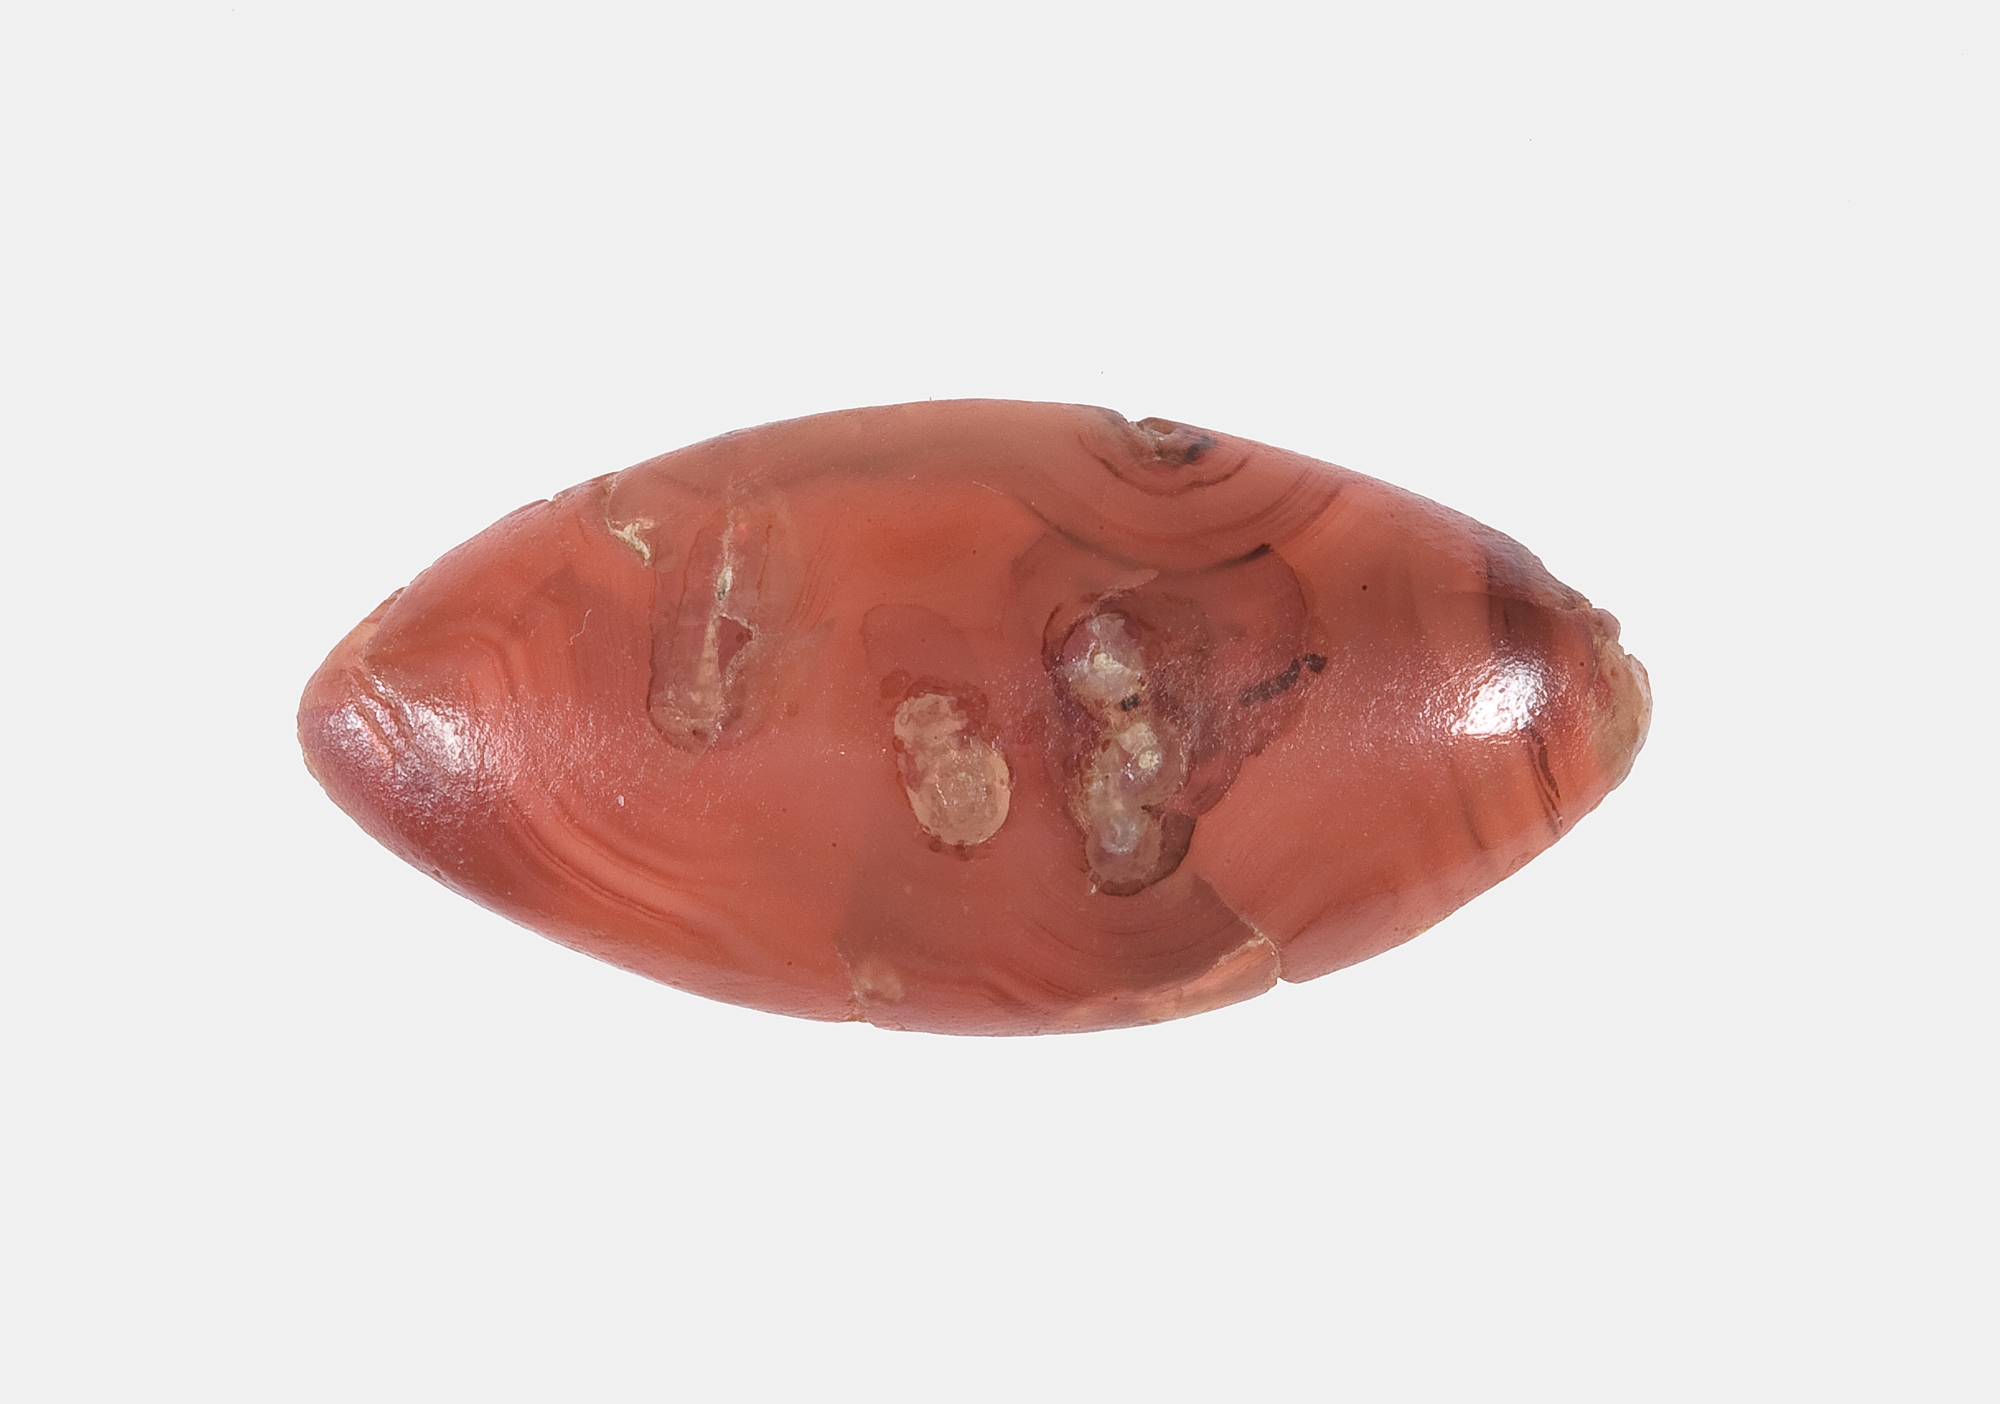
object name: amulet, sweret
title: Hepy, Sweret amulet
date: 1950-1885 BCE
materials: gemstone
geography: egypt